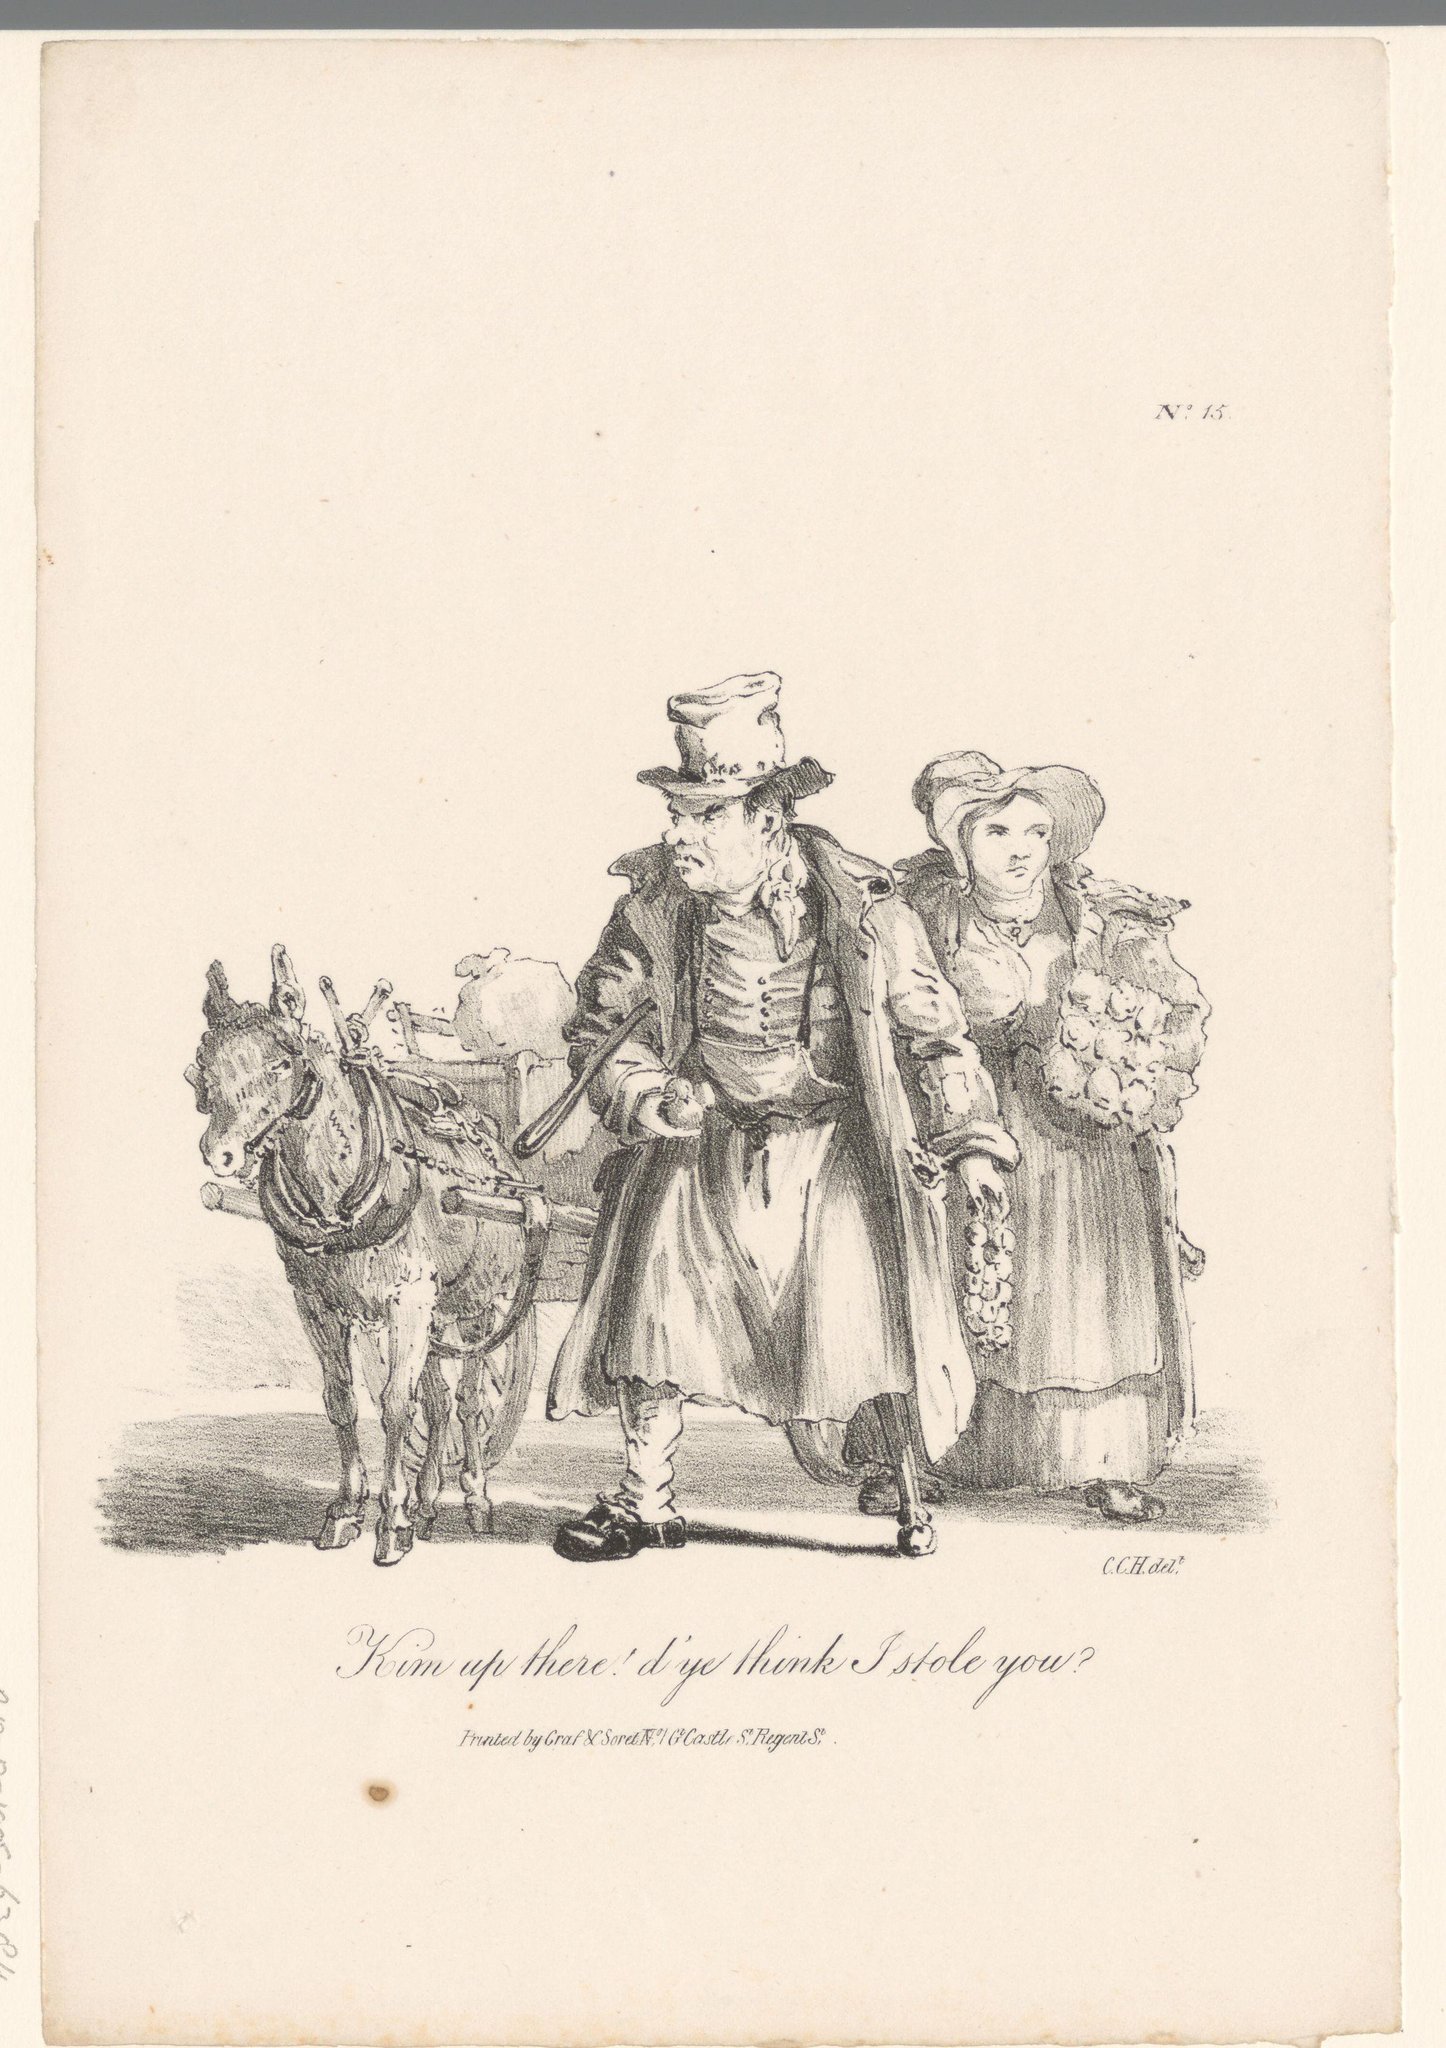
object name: cartoon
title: Kim up there! d'ye think i stole you?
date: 1830-1838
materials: paper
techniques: lithograph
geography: london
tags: two-wheeled, animal-drawn vehicle, satire on marriage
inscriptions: collector's mark: Lugt 2228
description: Prent maakt deel uit van een serie met spotprenten. Over deze serie is verder niets bekend. Het betreft voornamelijk voorstellingen over de Engelse bevolking.